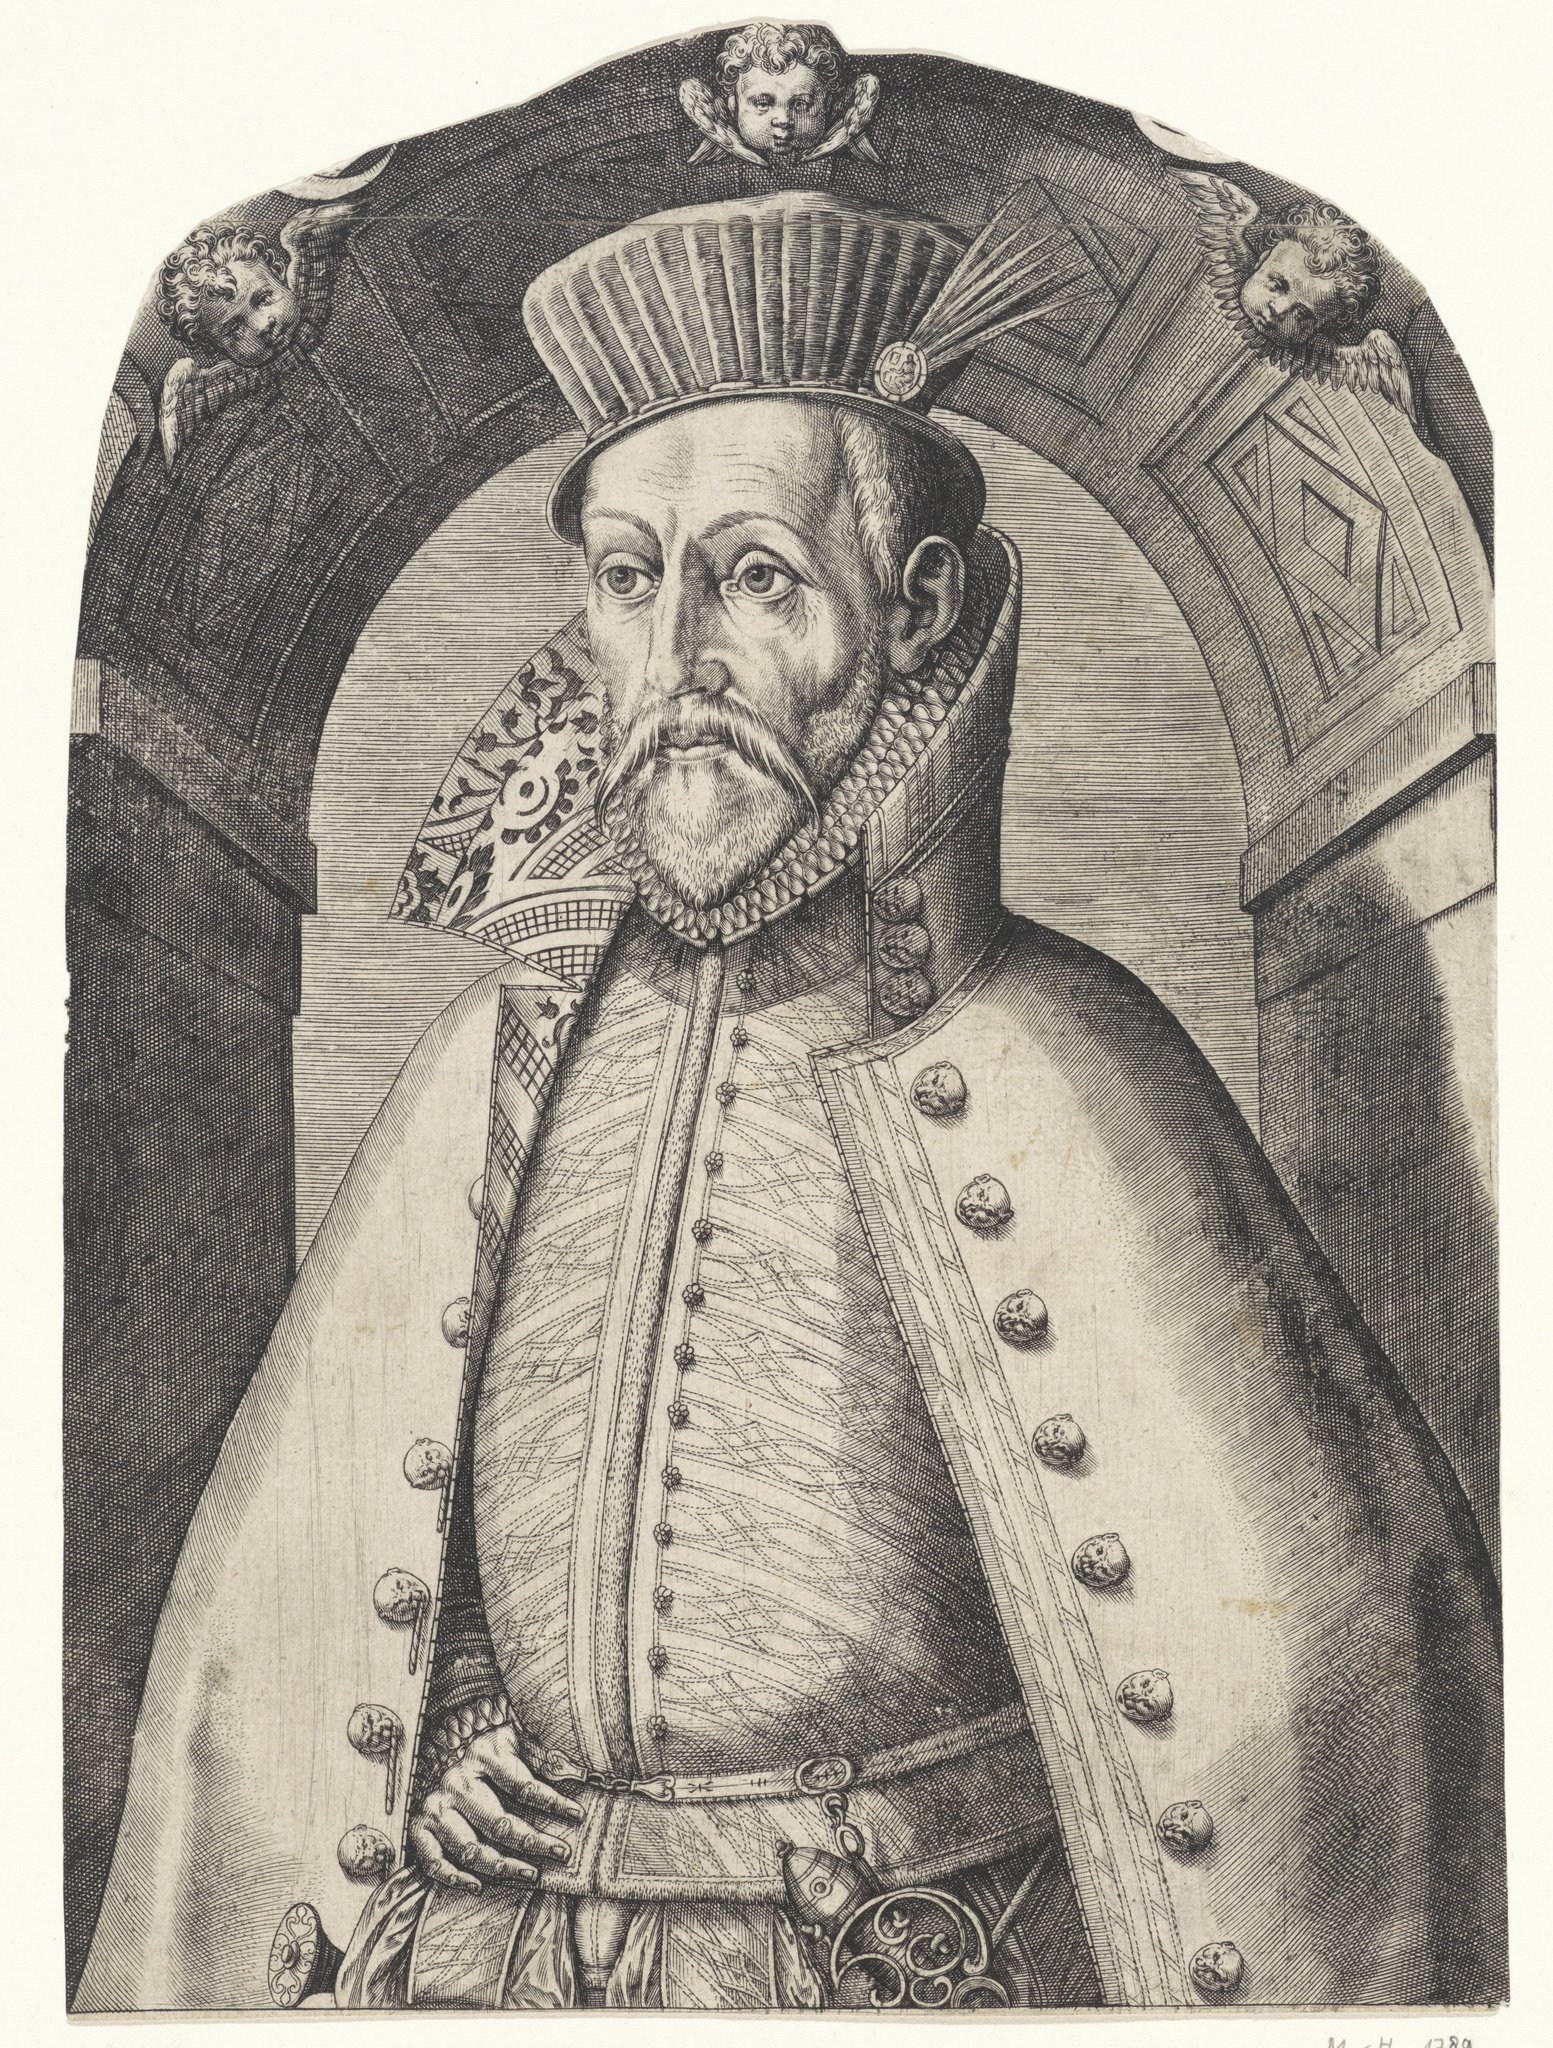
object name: print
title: Portret van Gaspard de Coligny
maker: Anonymous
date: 1550-1600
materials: paper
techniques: engraving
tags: paris, politician, gaspard de coligny (ii), cherubs, i.e. children's heads with wings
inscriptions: collector's mark: Lugt 2228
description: Hij draagt een geplooide hoed, de knopen van zijn mantel bestaan uit saterkoppen. Hij staat onder een rondboog versierd met drie cherubijnen.